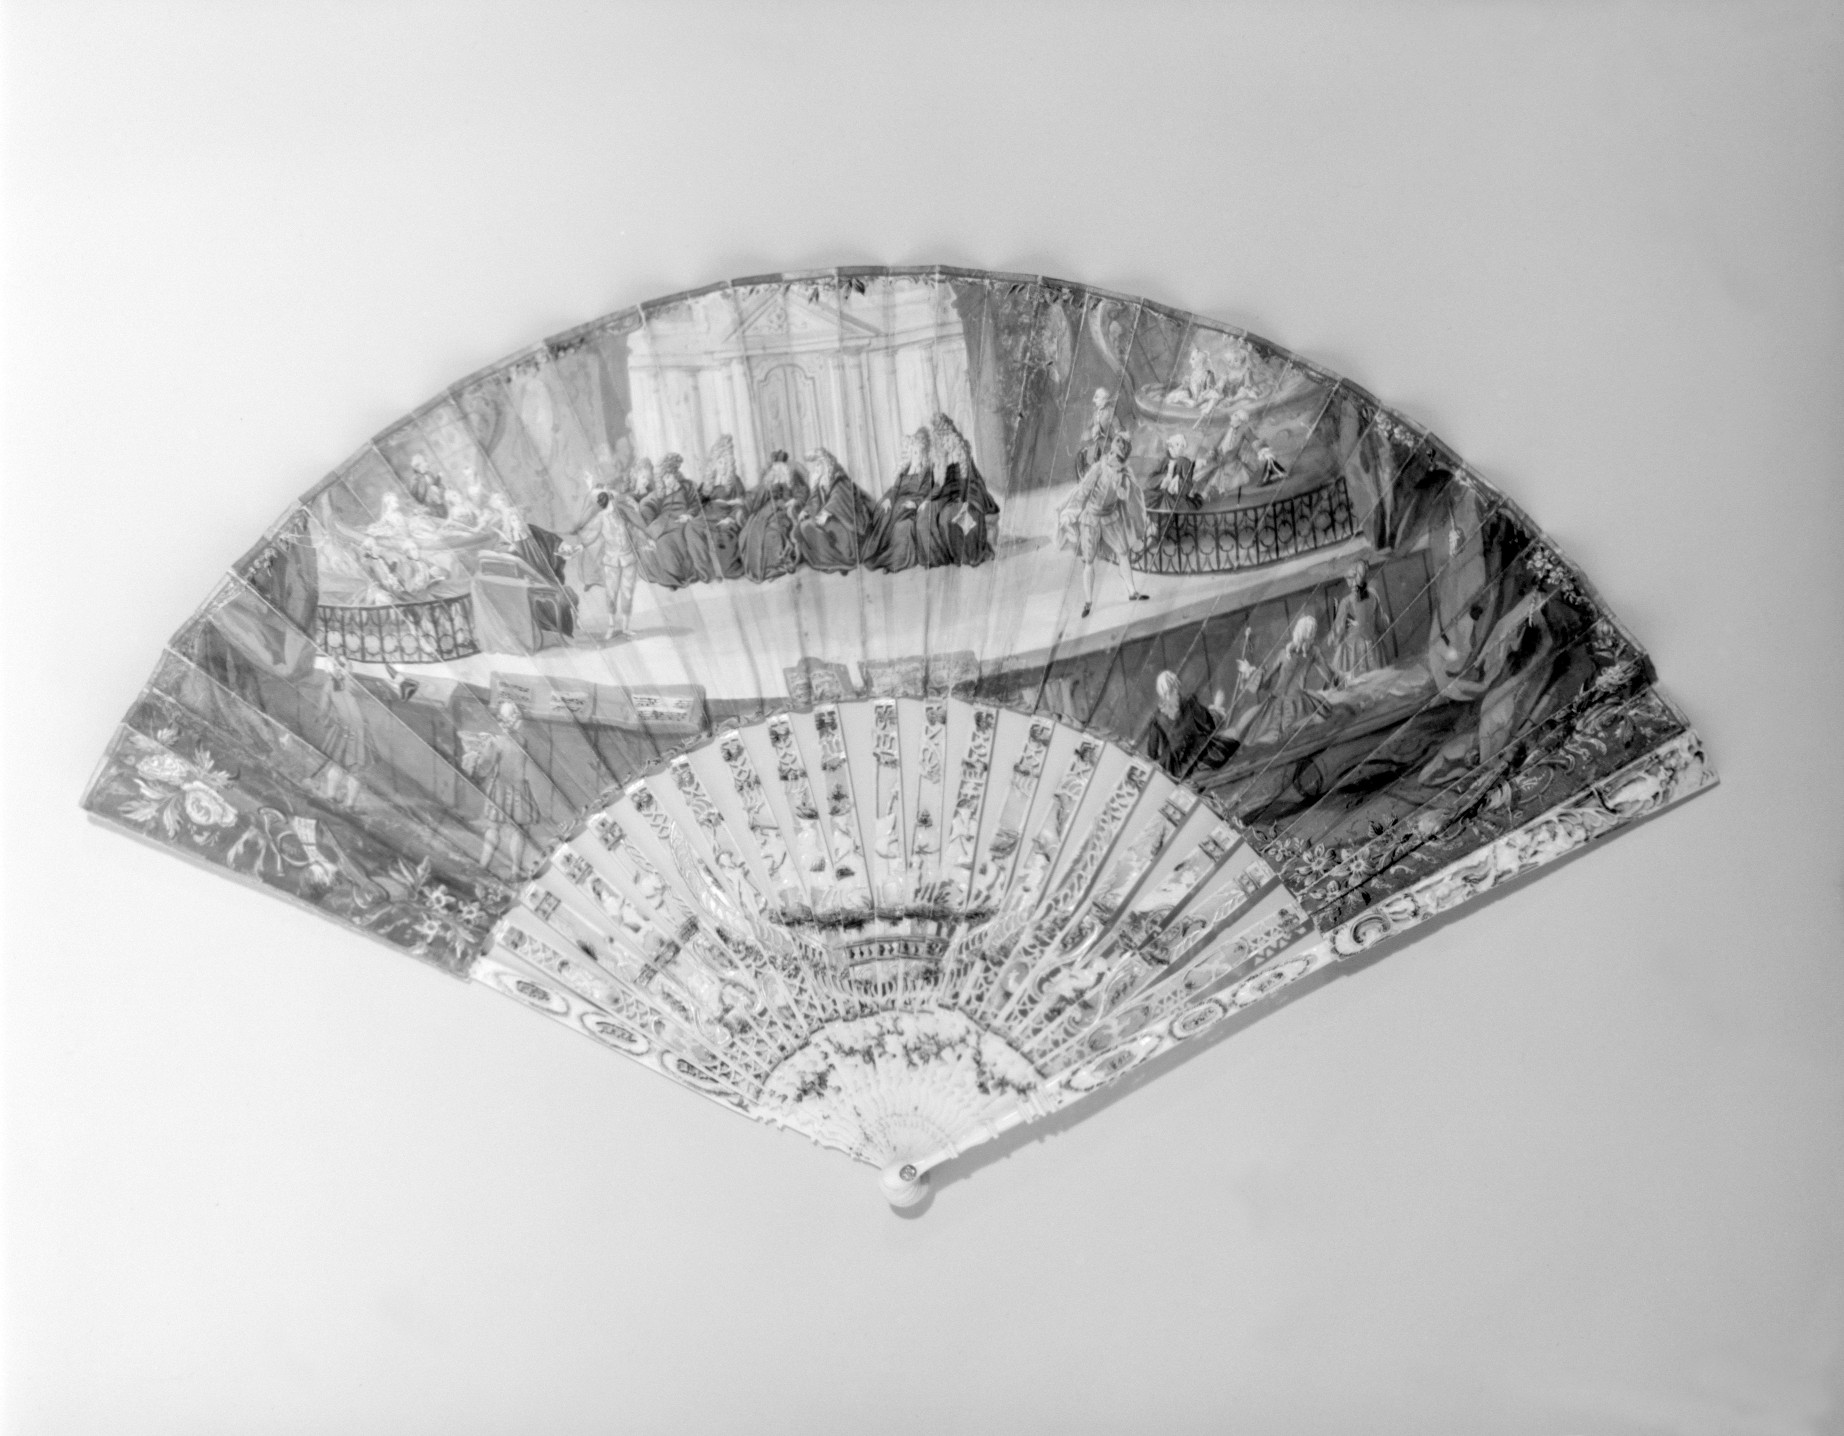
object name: fan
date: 1701-1800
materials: ivory, paper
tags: theatre,buildings,men,women,drinking